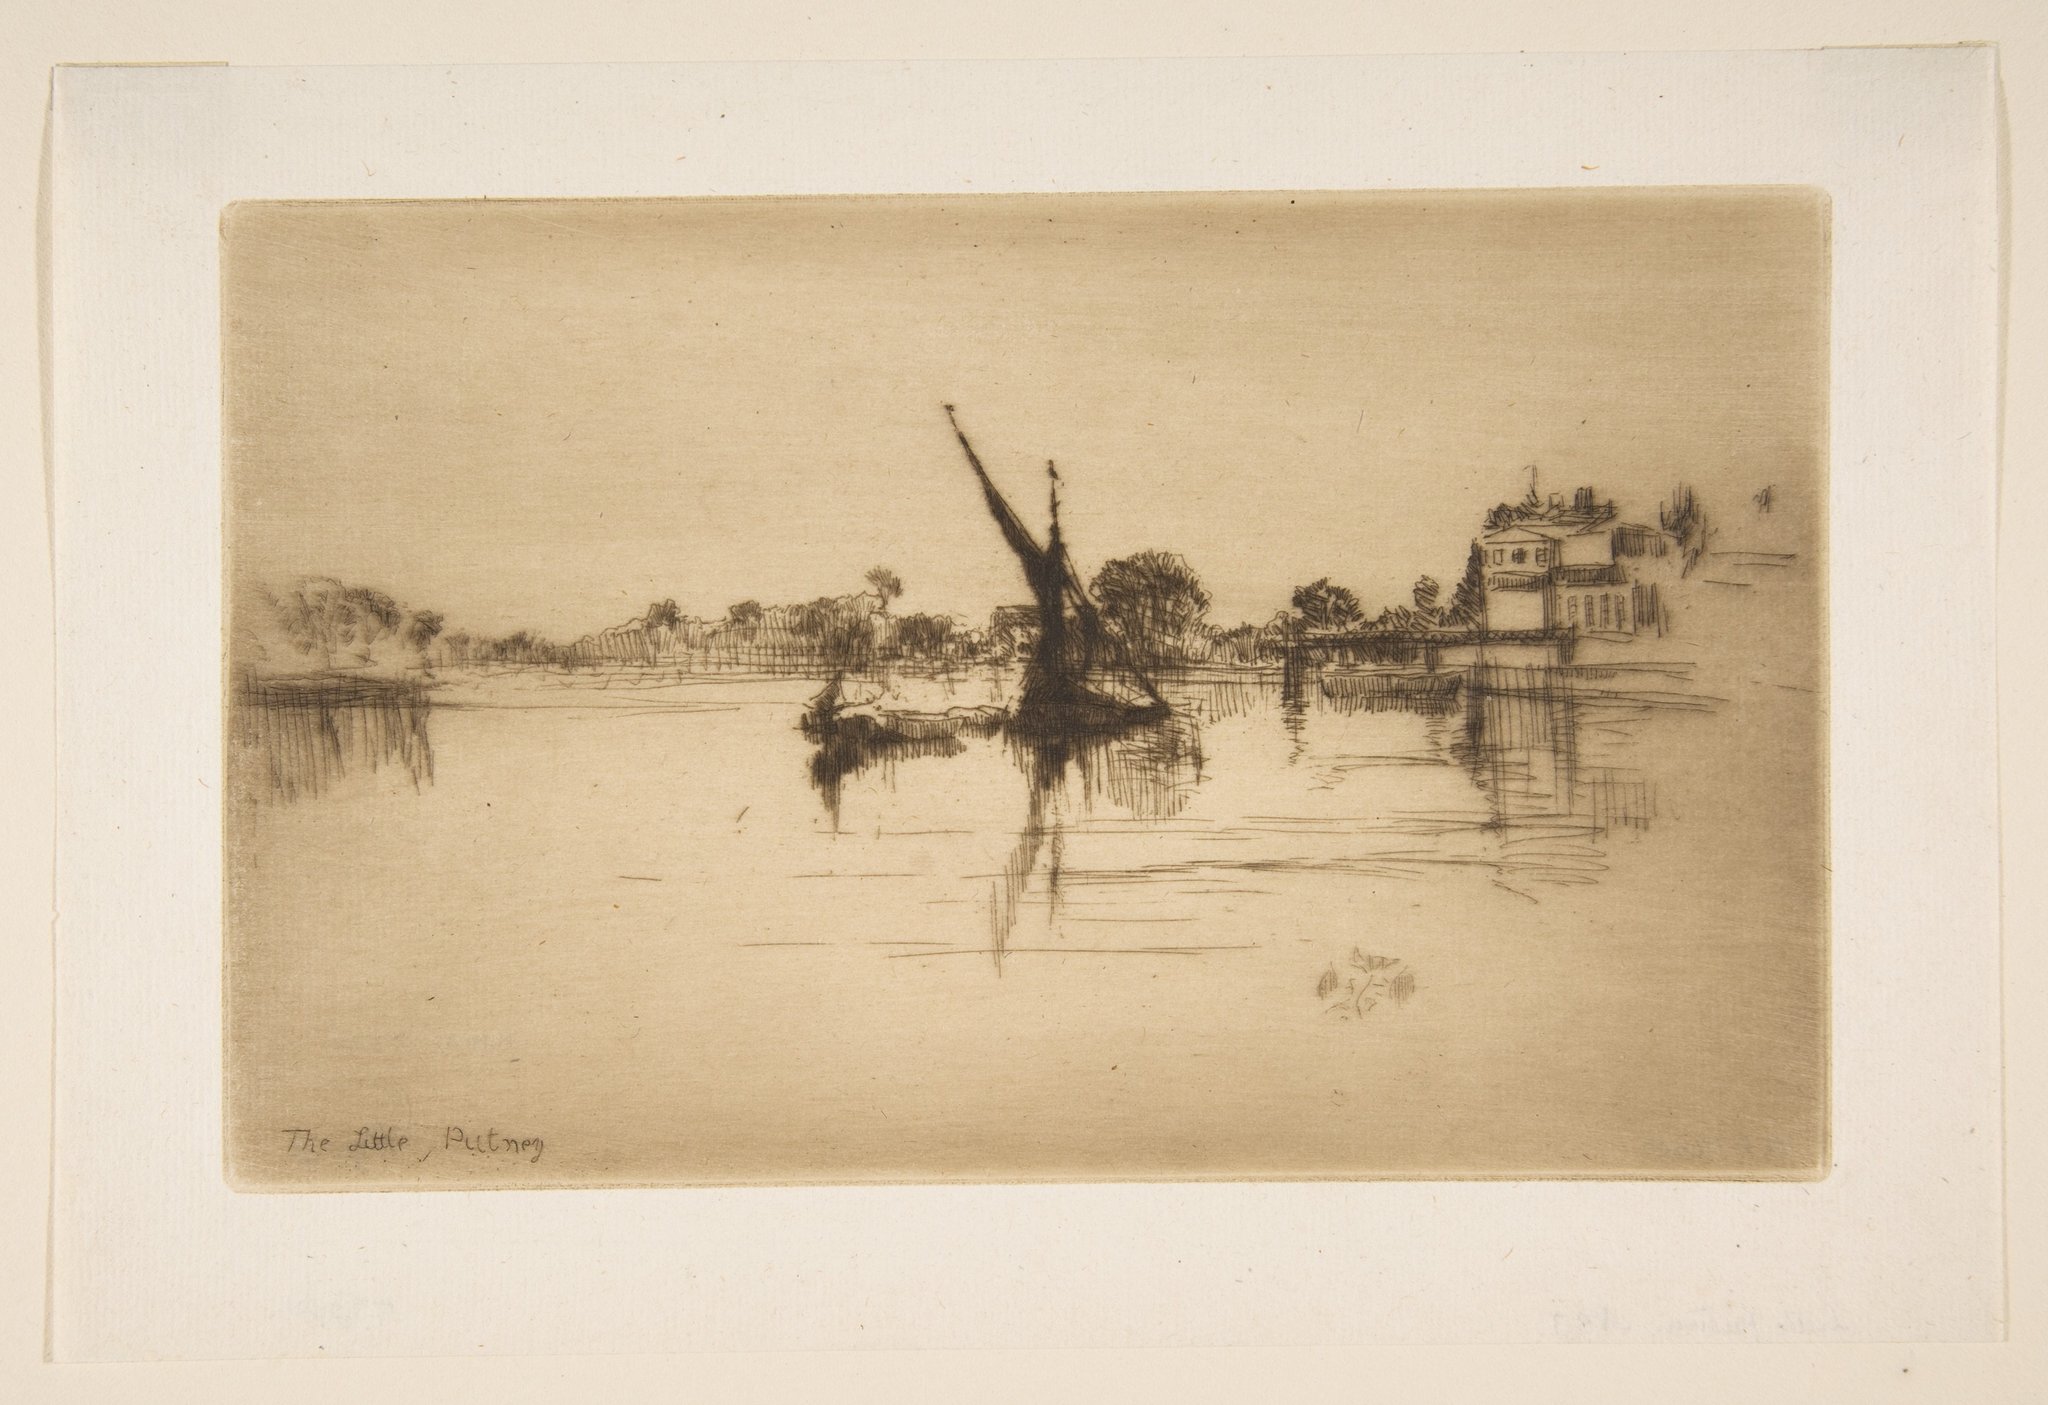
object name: print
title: Little Putney, No. 2 (The Little Putney)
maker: james mcneill whistler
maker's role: artist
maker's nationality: american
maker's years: 1834-1903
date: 1879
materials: ink, paper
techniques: drypoint, etching, printing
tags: rivers,boats